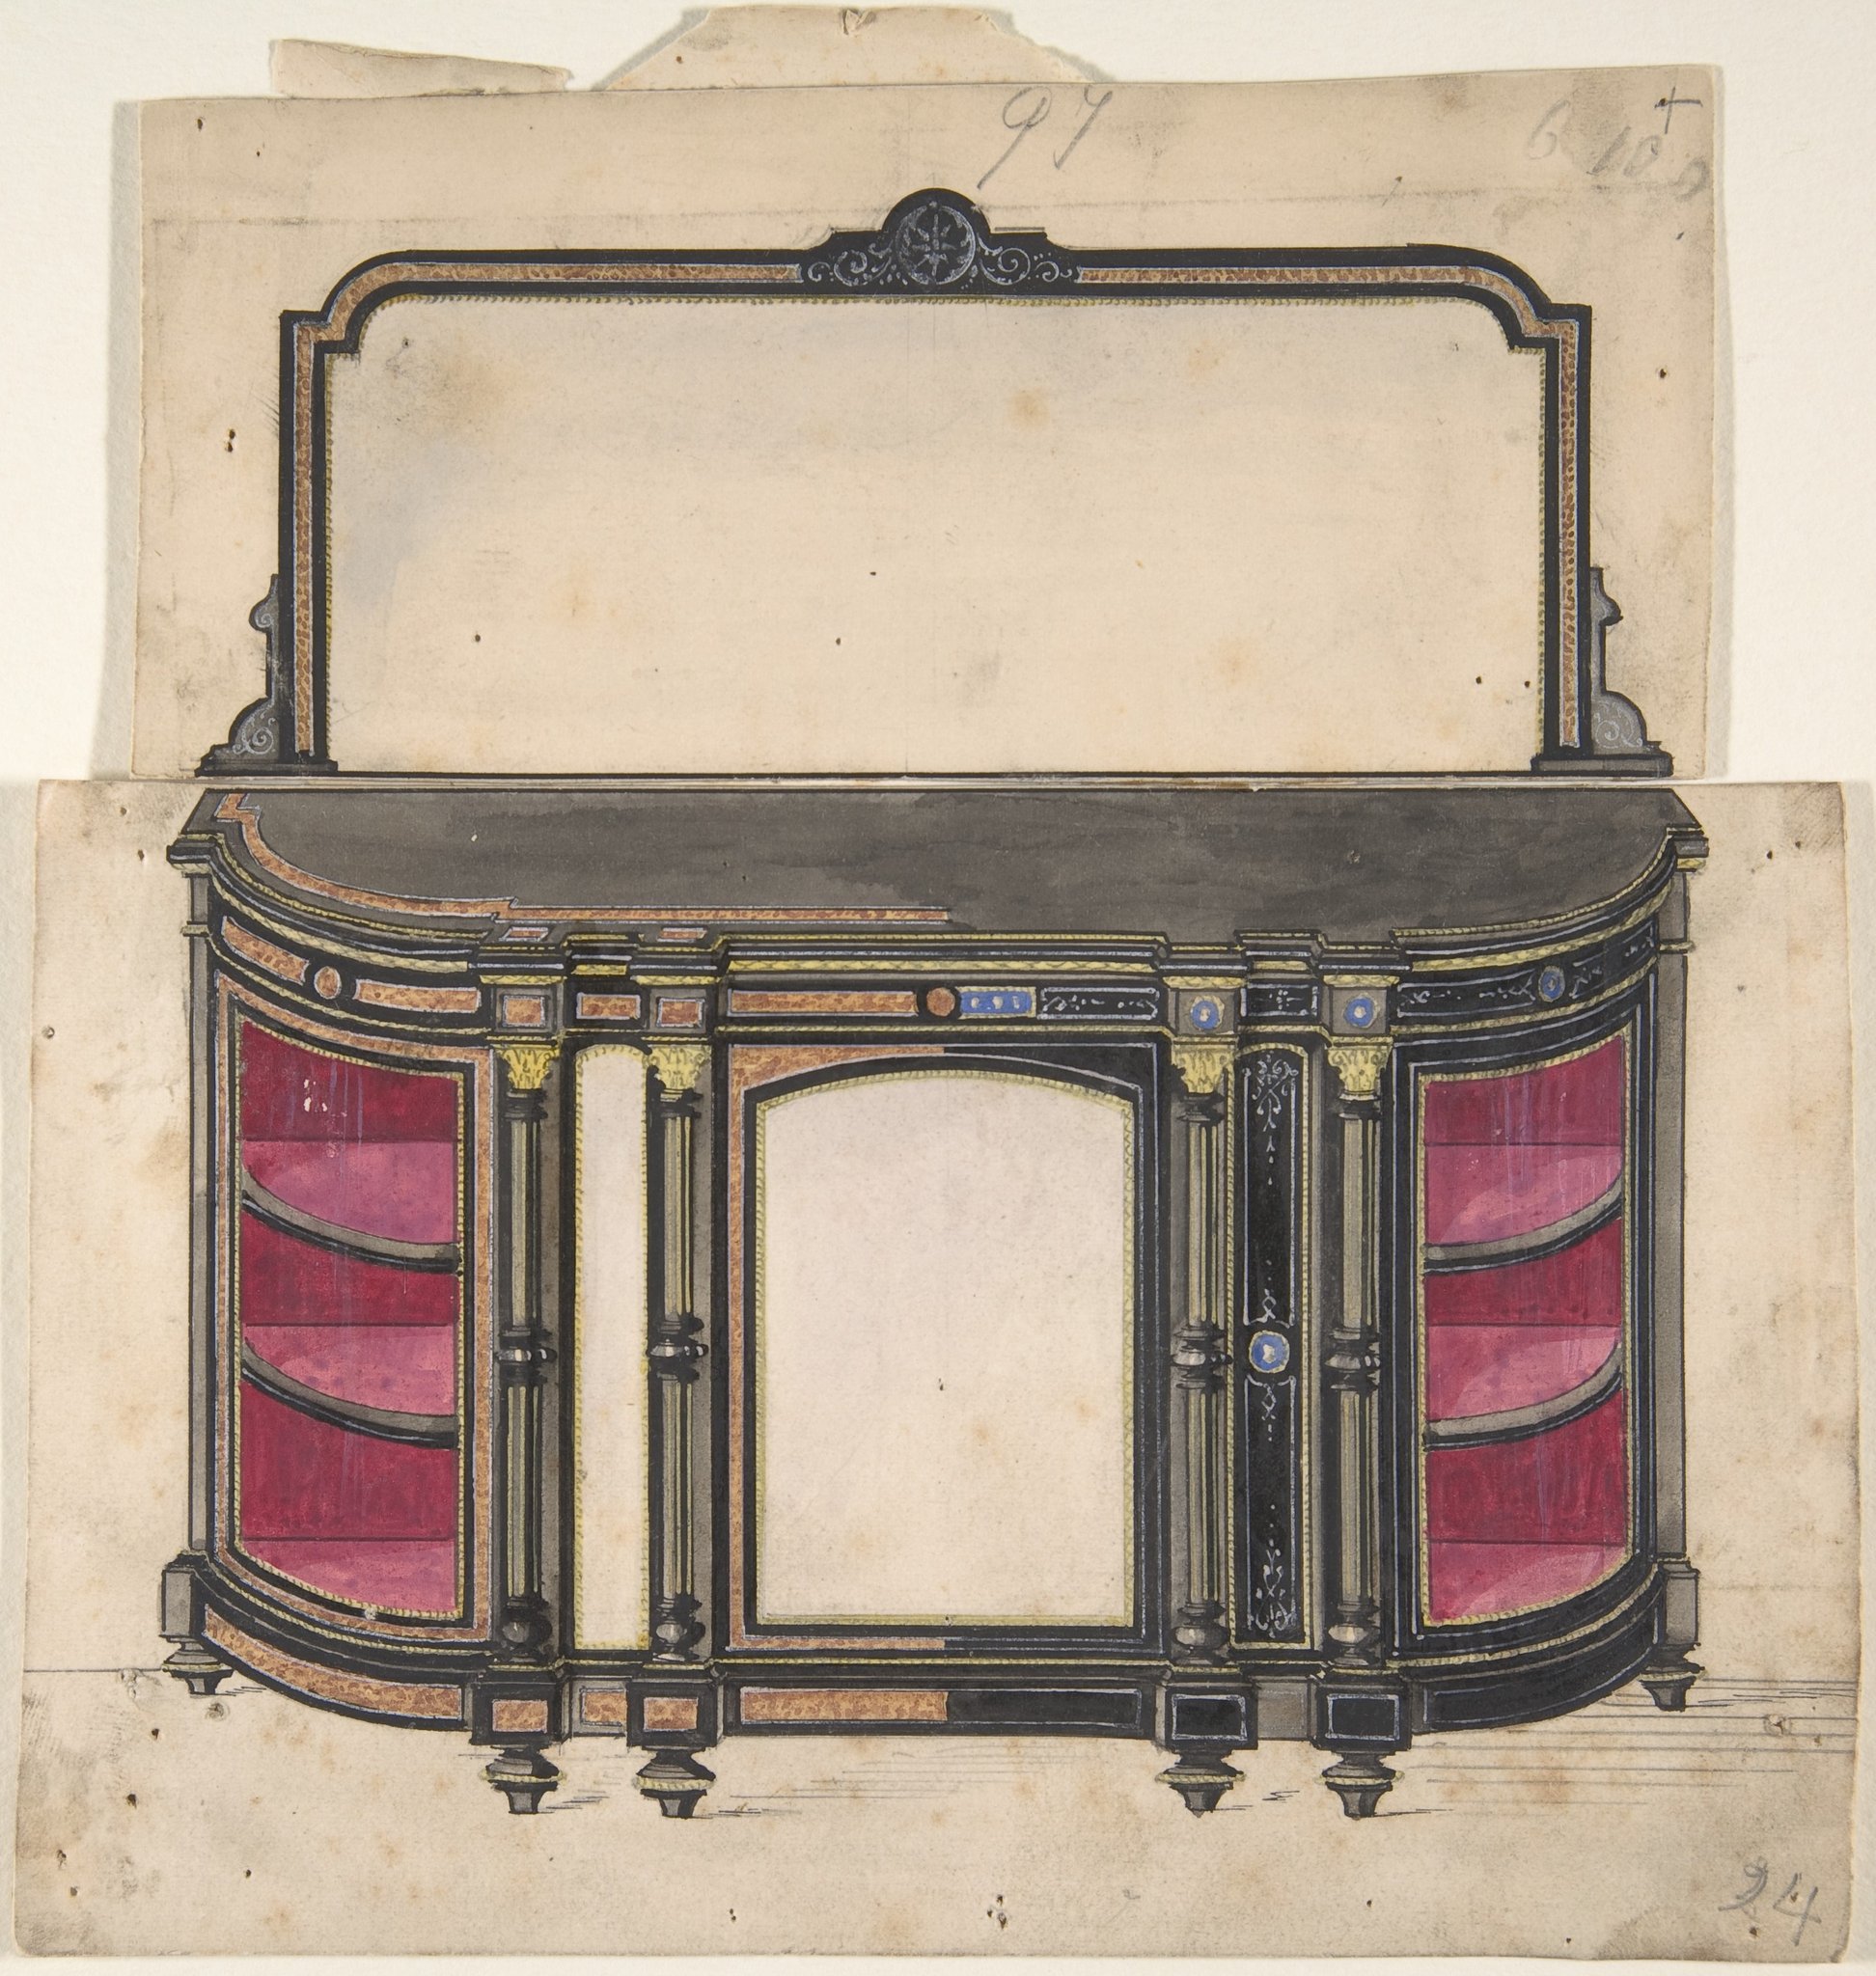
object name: drawing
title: Cabinet Design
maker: anonymous, british, 19th century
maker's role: artist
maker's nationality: british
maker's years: 1800-1900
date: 1801-1900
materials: ink, watercolor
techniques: pen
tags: cabinets